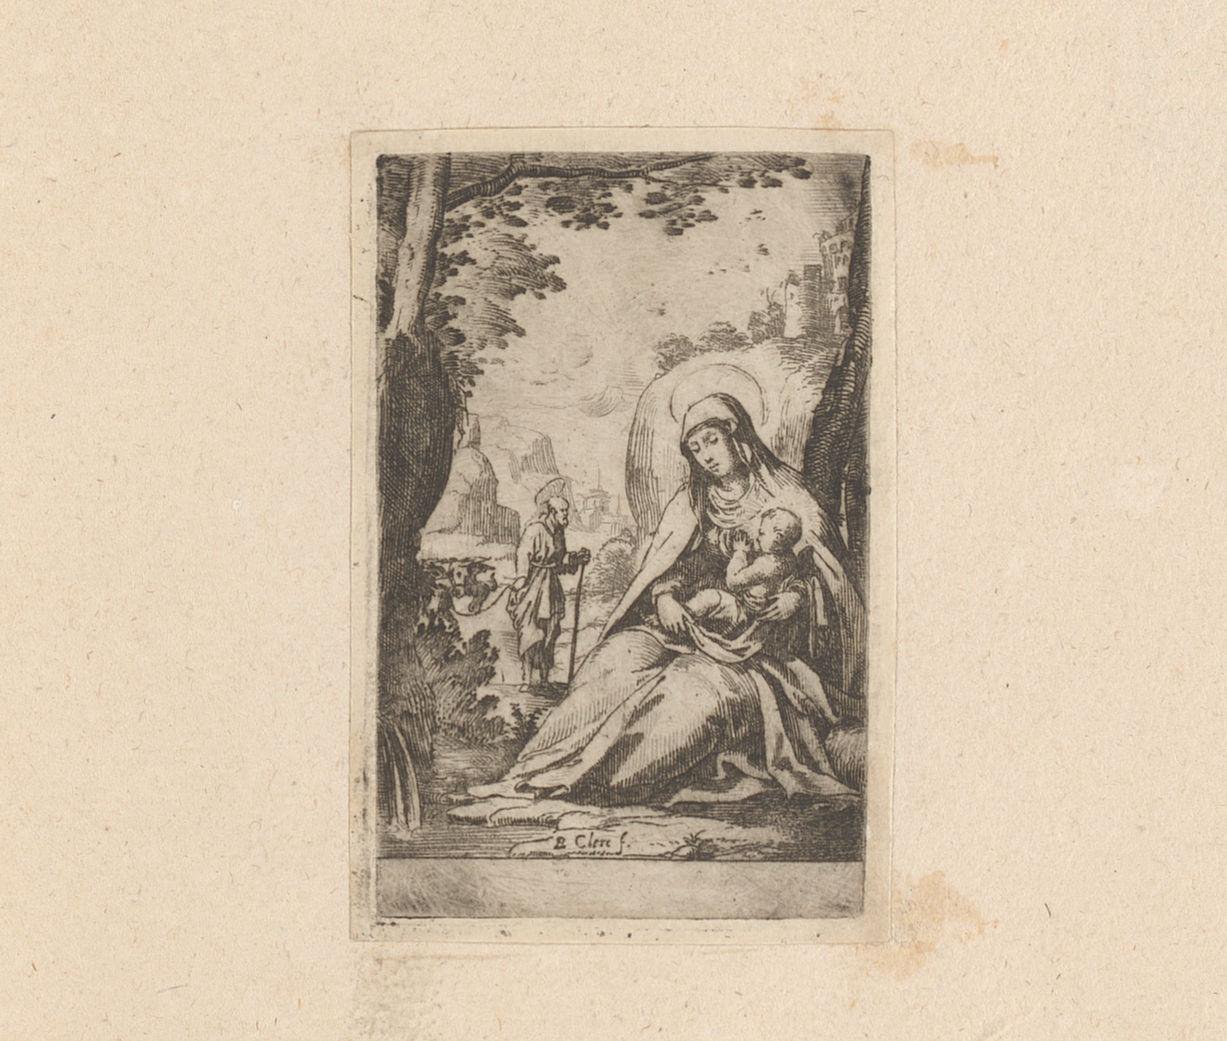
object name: album leaf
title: Les tableaux parlans de la vie morale et mondaine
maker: sébastien leclerc (i)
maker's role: print maker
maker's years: 1637-1714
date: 1655-1683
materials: paper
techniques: etching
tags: rest on the flight into egypt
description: Maakt deel uit van een negendelige serie.